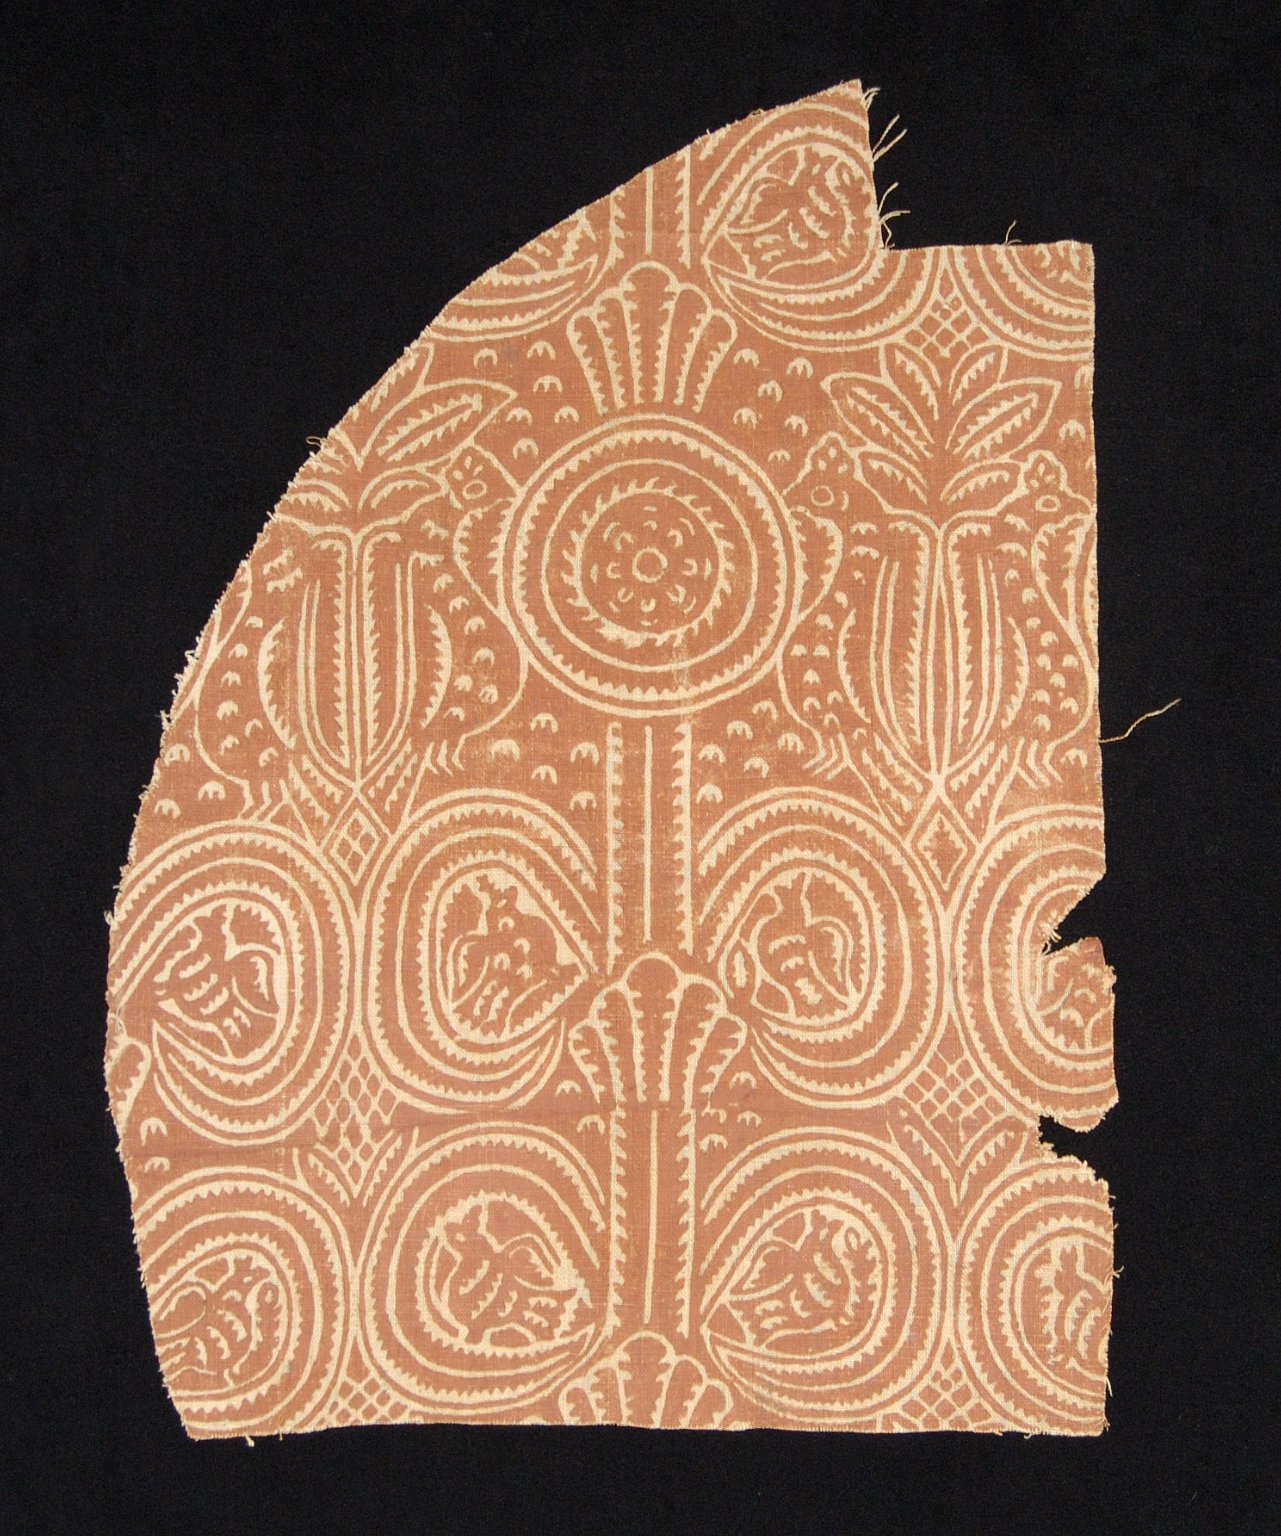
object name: fragment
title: Textile fragment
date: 1700-1899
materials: linen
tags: birds